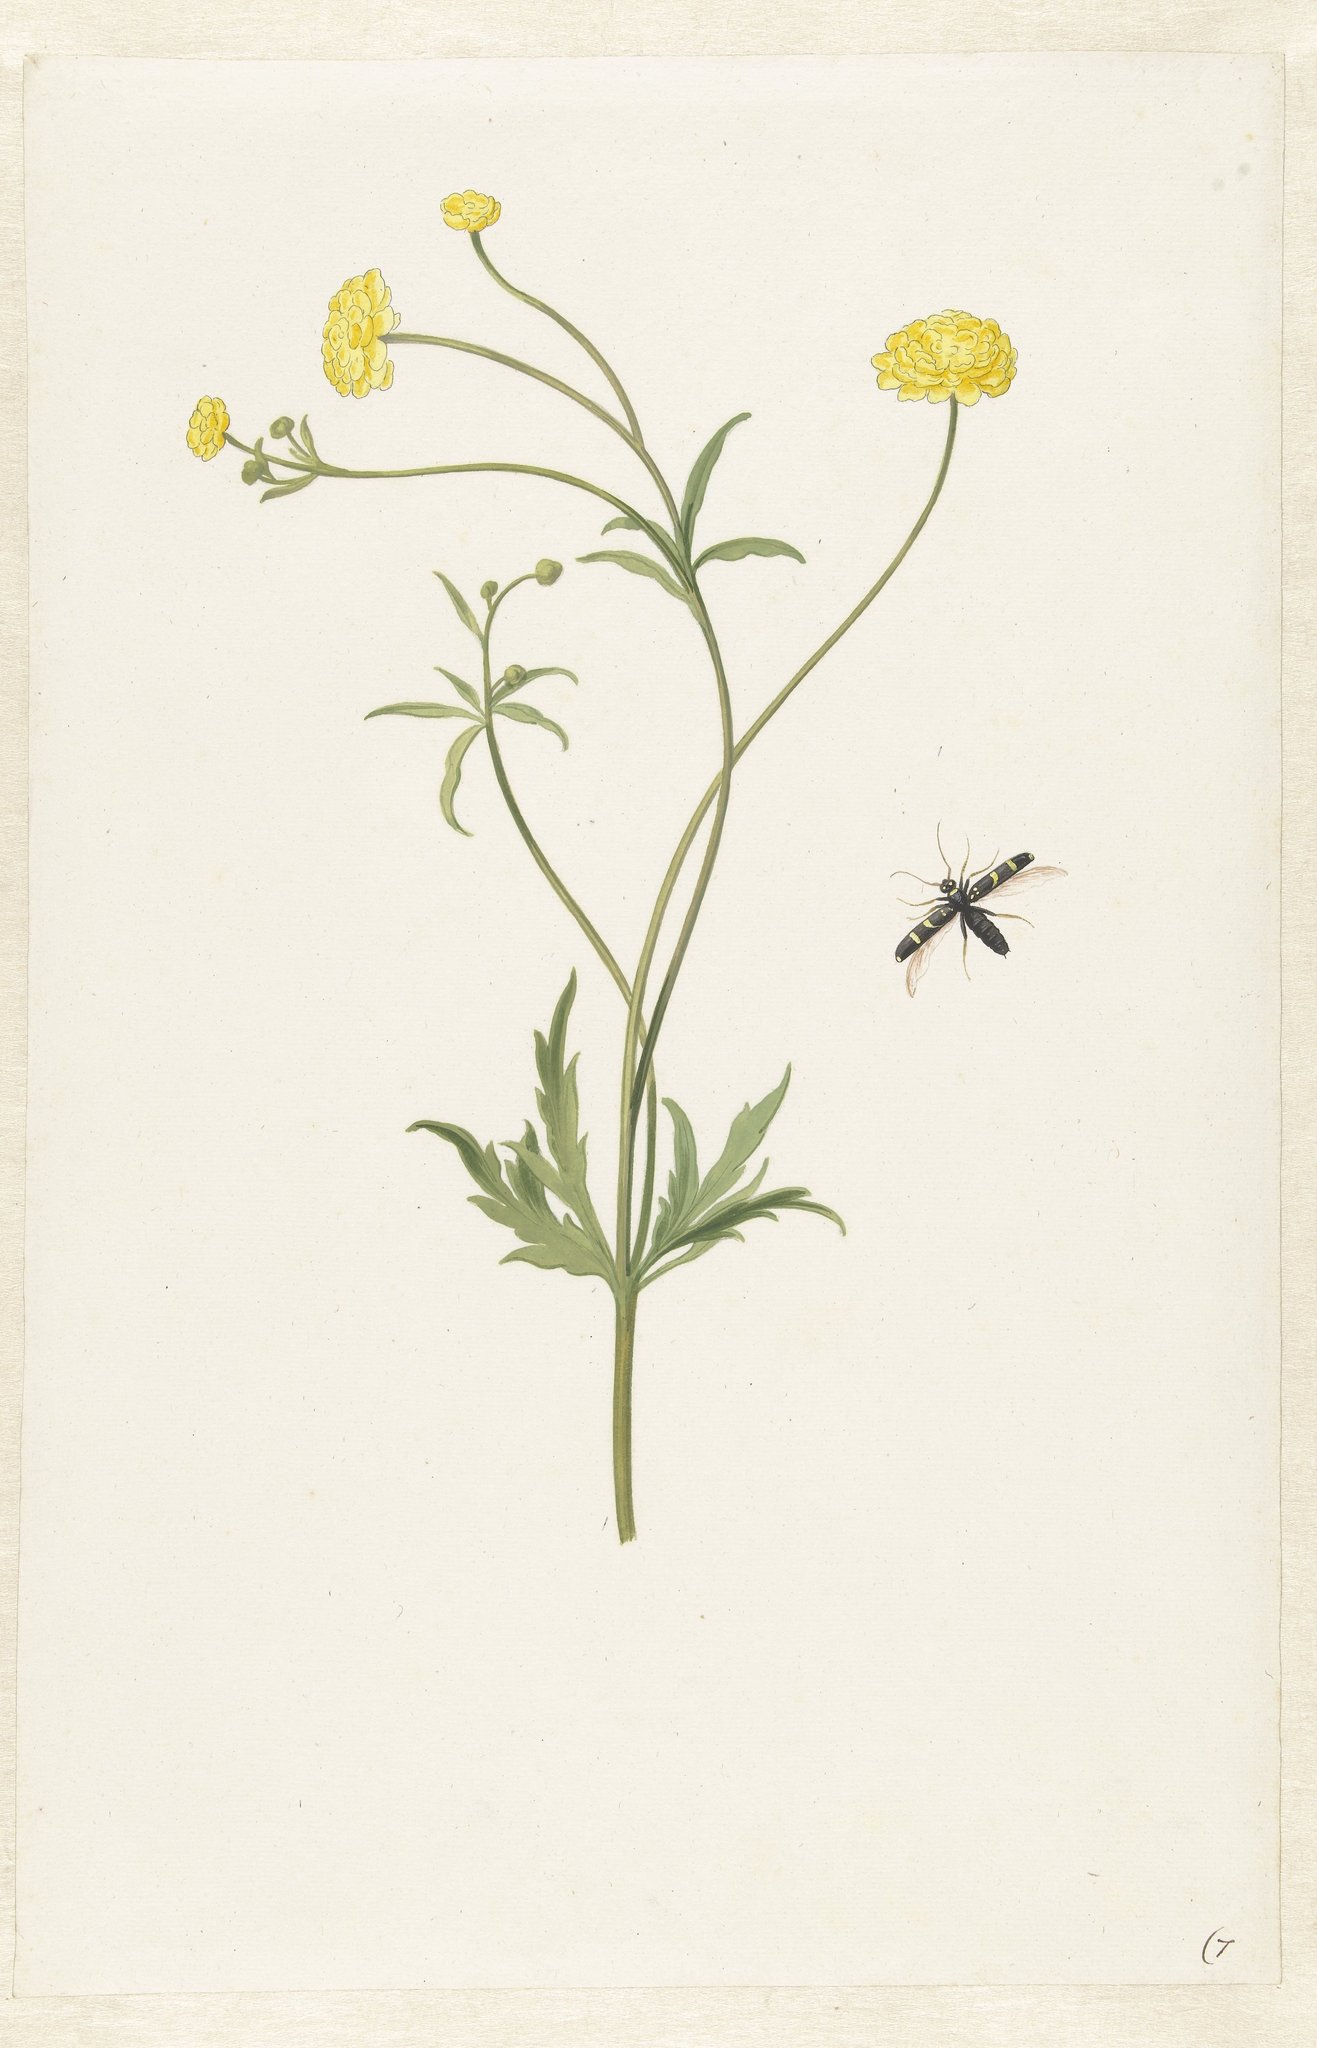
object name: drawing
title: Dubbele gele ranonkel en insekt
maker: pieter withoos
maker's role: draughtsman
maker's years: 1654-1693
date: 1674-1692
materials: paper, watercolor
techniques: brush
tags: flowers: turban buttercup, insects: beetle